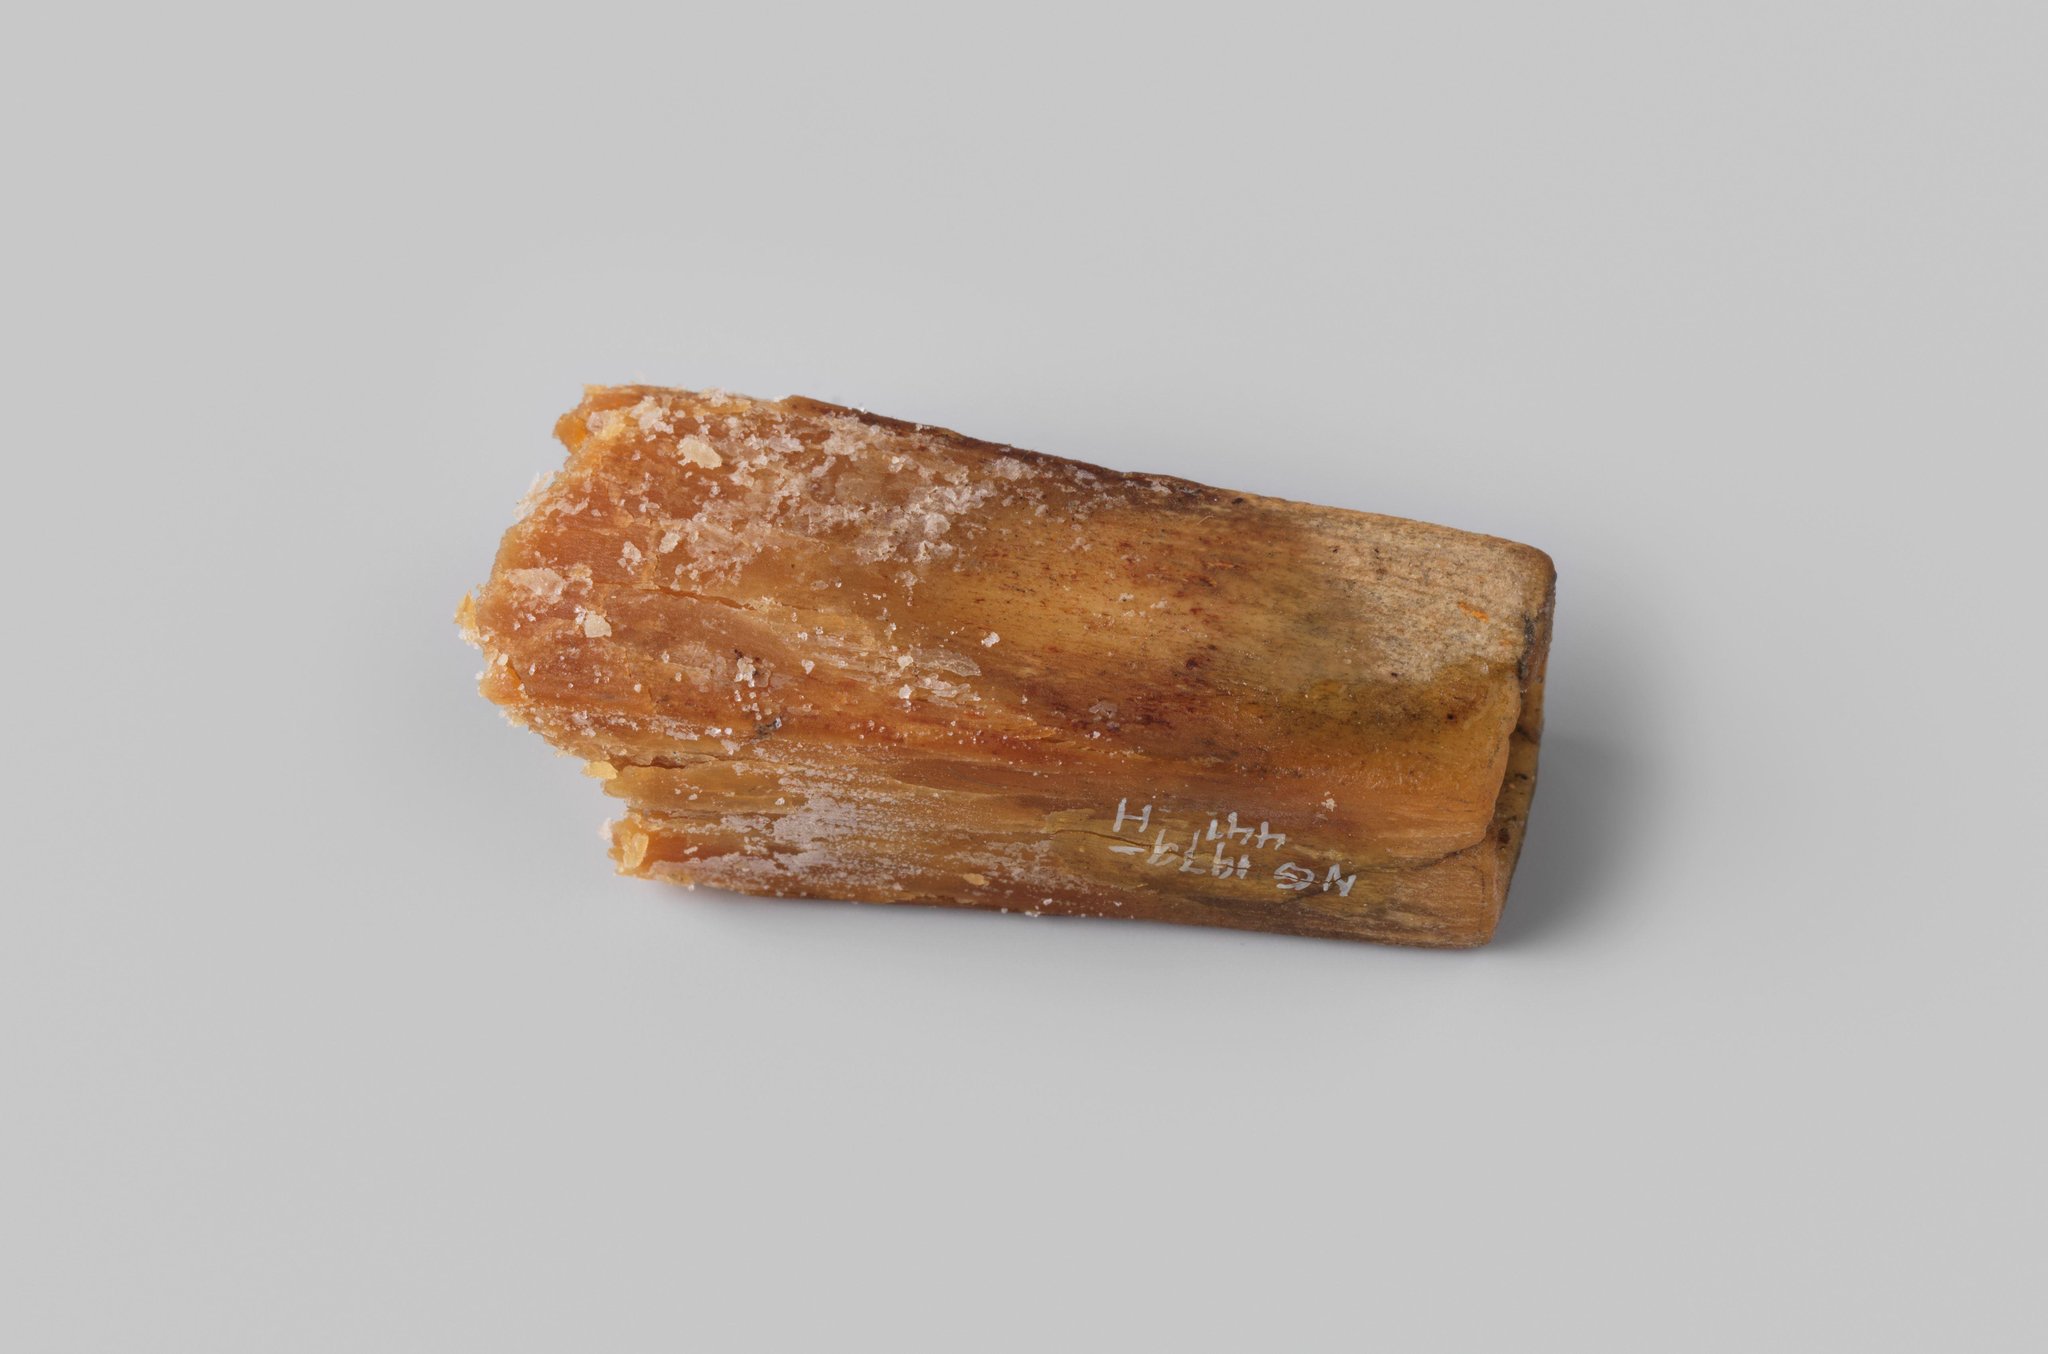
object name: fragment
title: Benen fragment uit het wrak van de Oost-Indiëvaarder Hollandia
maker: Anonymous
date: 1700-1743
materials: bone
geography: netherlands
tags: verenigde oostindische compagnie, hollandia (schip), annet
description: Varied parts or fragments, tubes and tube-shaped fragments; straight, exterior rectangular in section, tapering to square, straight ends, hollow core, oval, tapering.